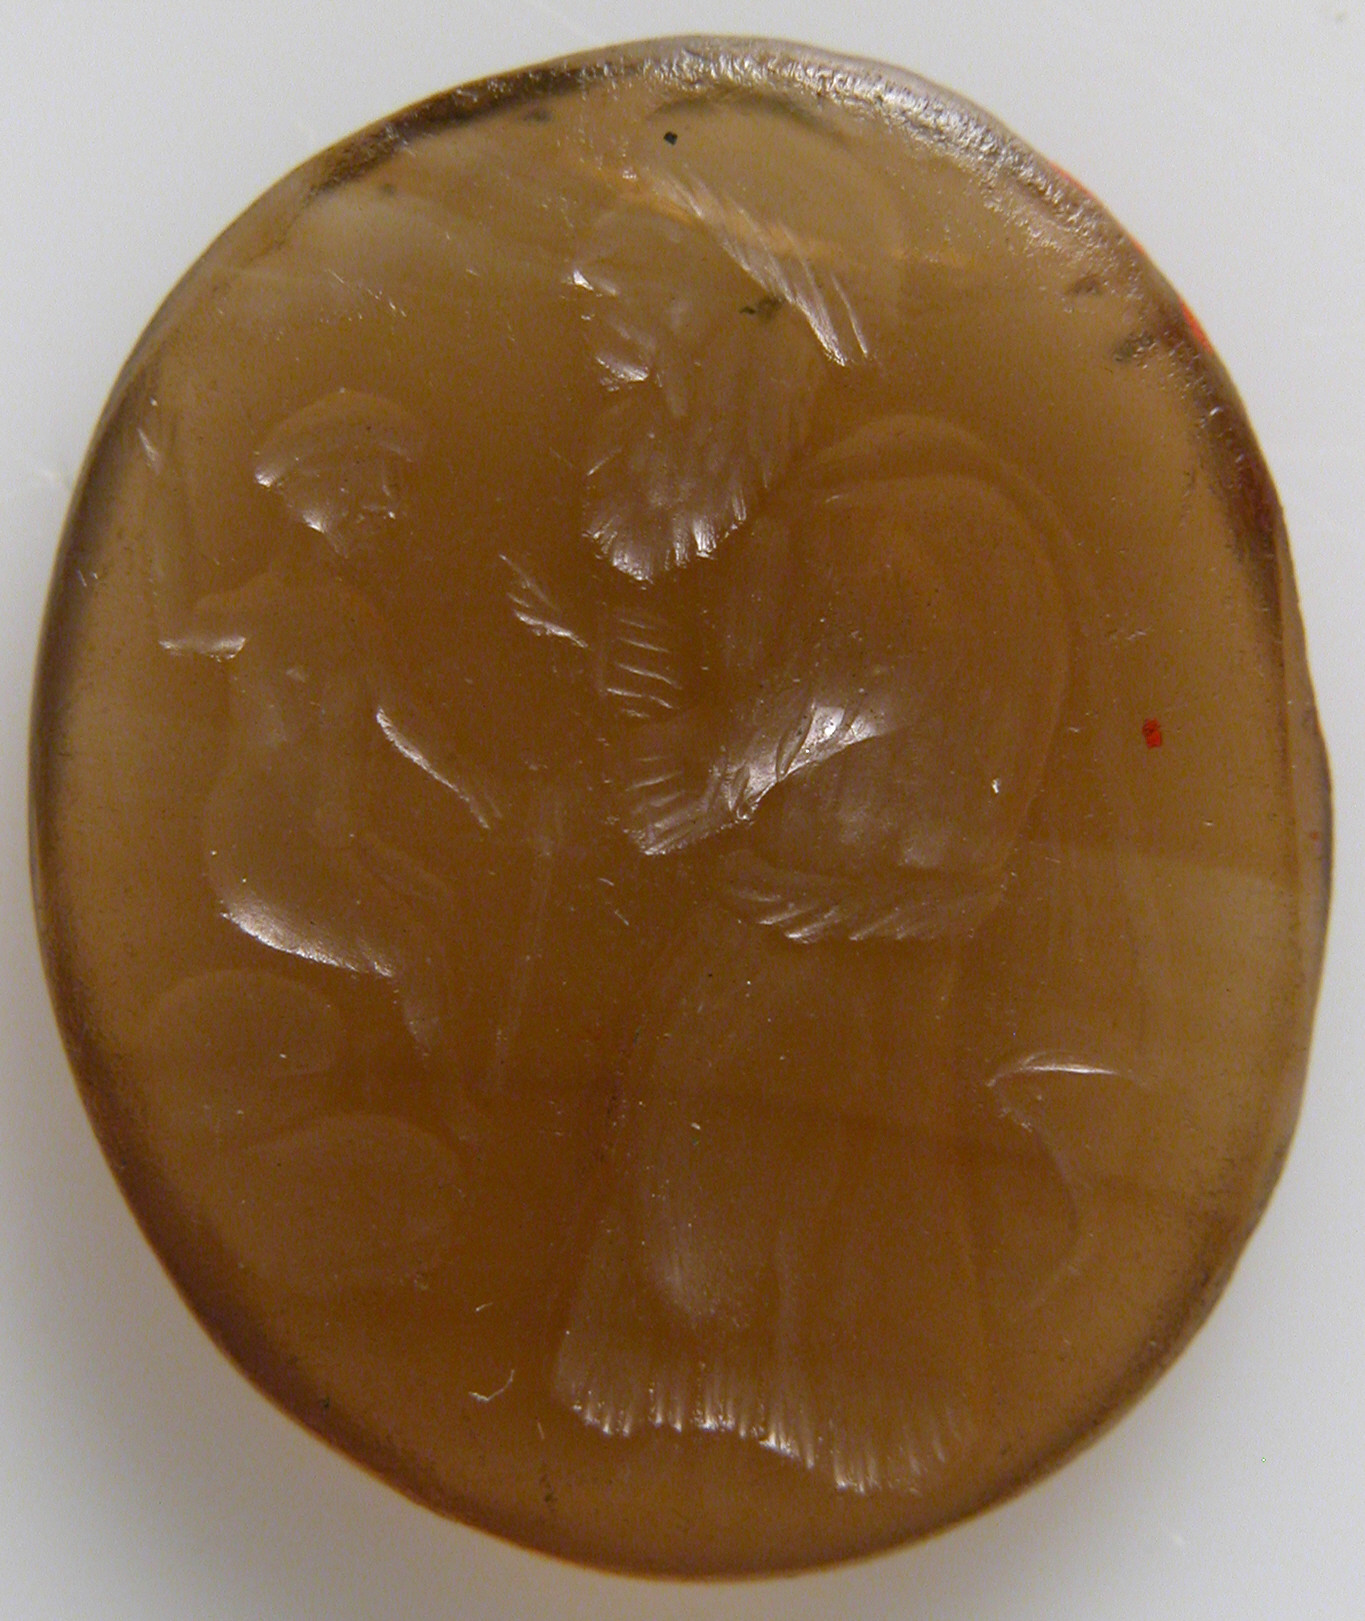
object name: intaglio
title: Christ Before The Elders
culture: roman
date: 250-500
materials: stone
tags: men